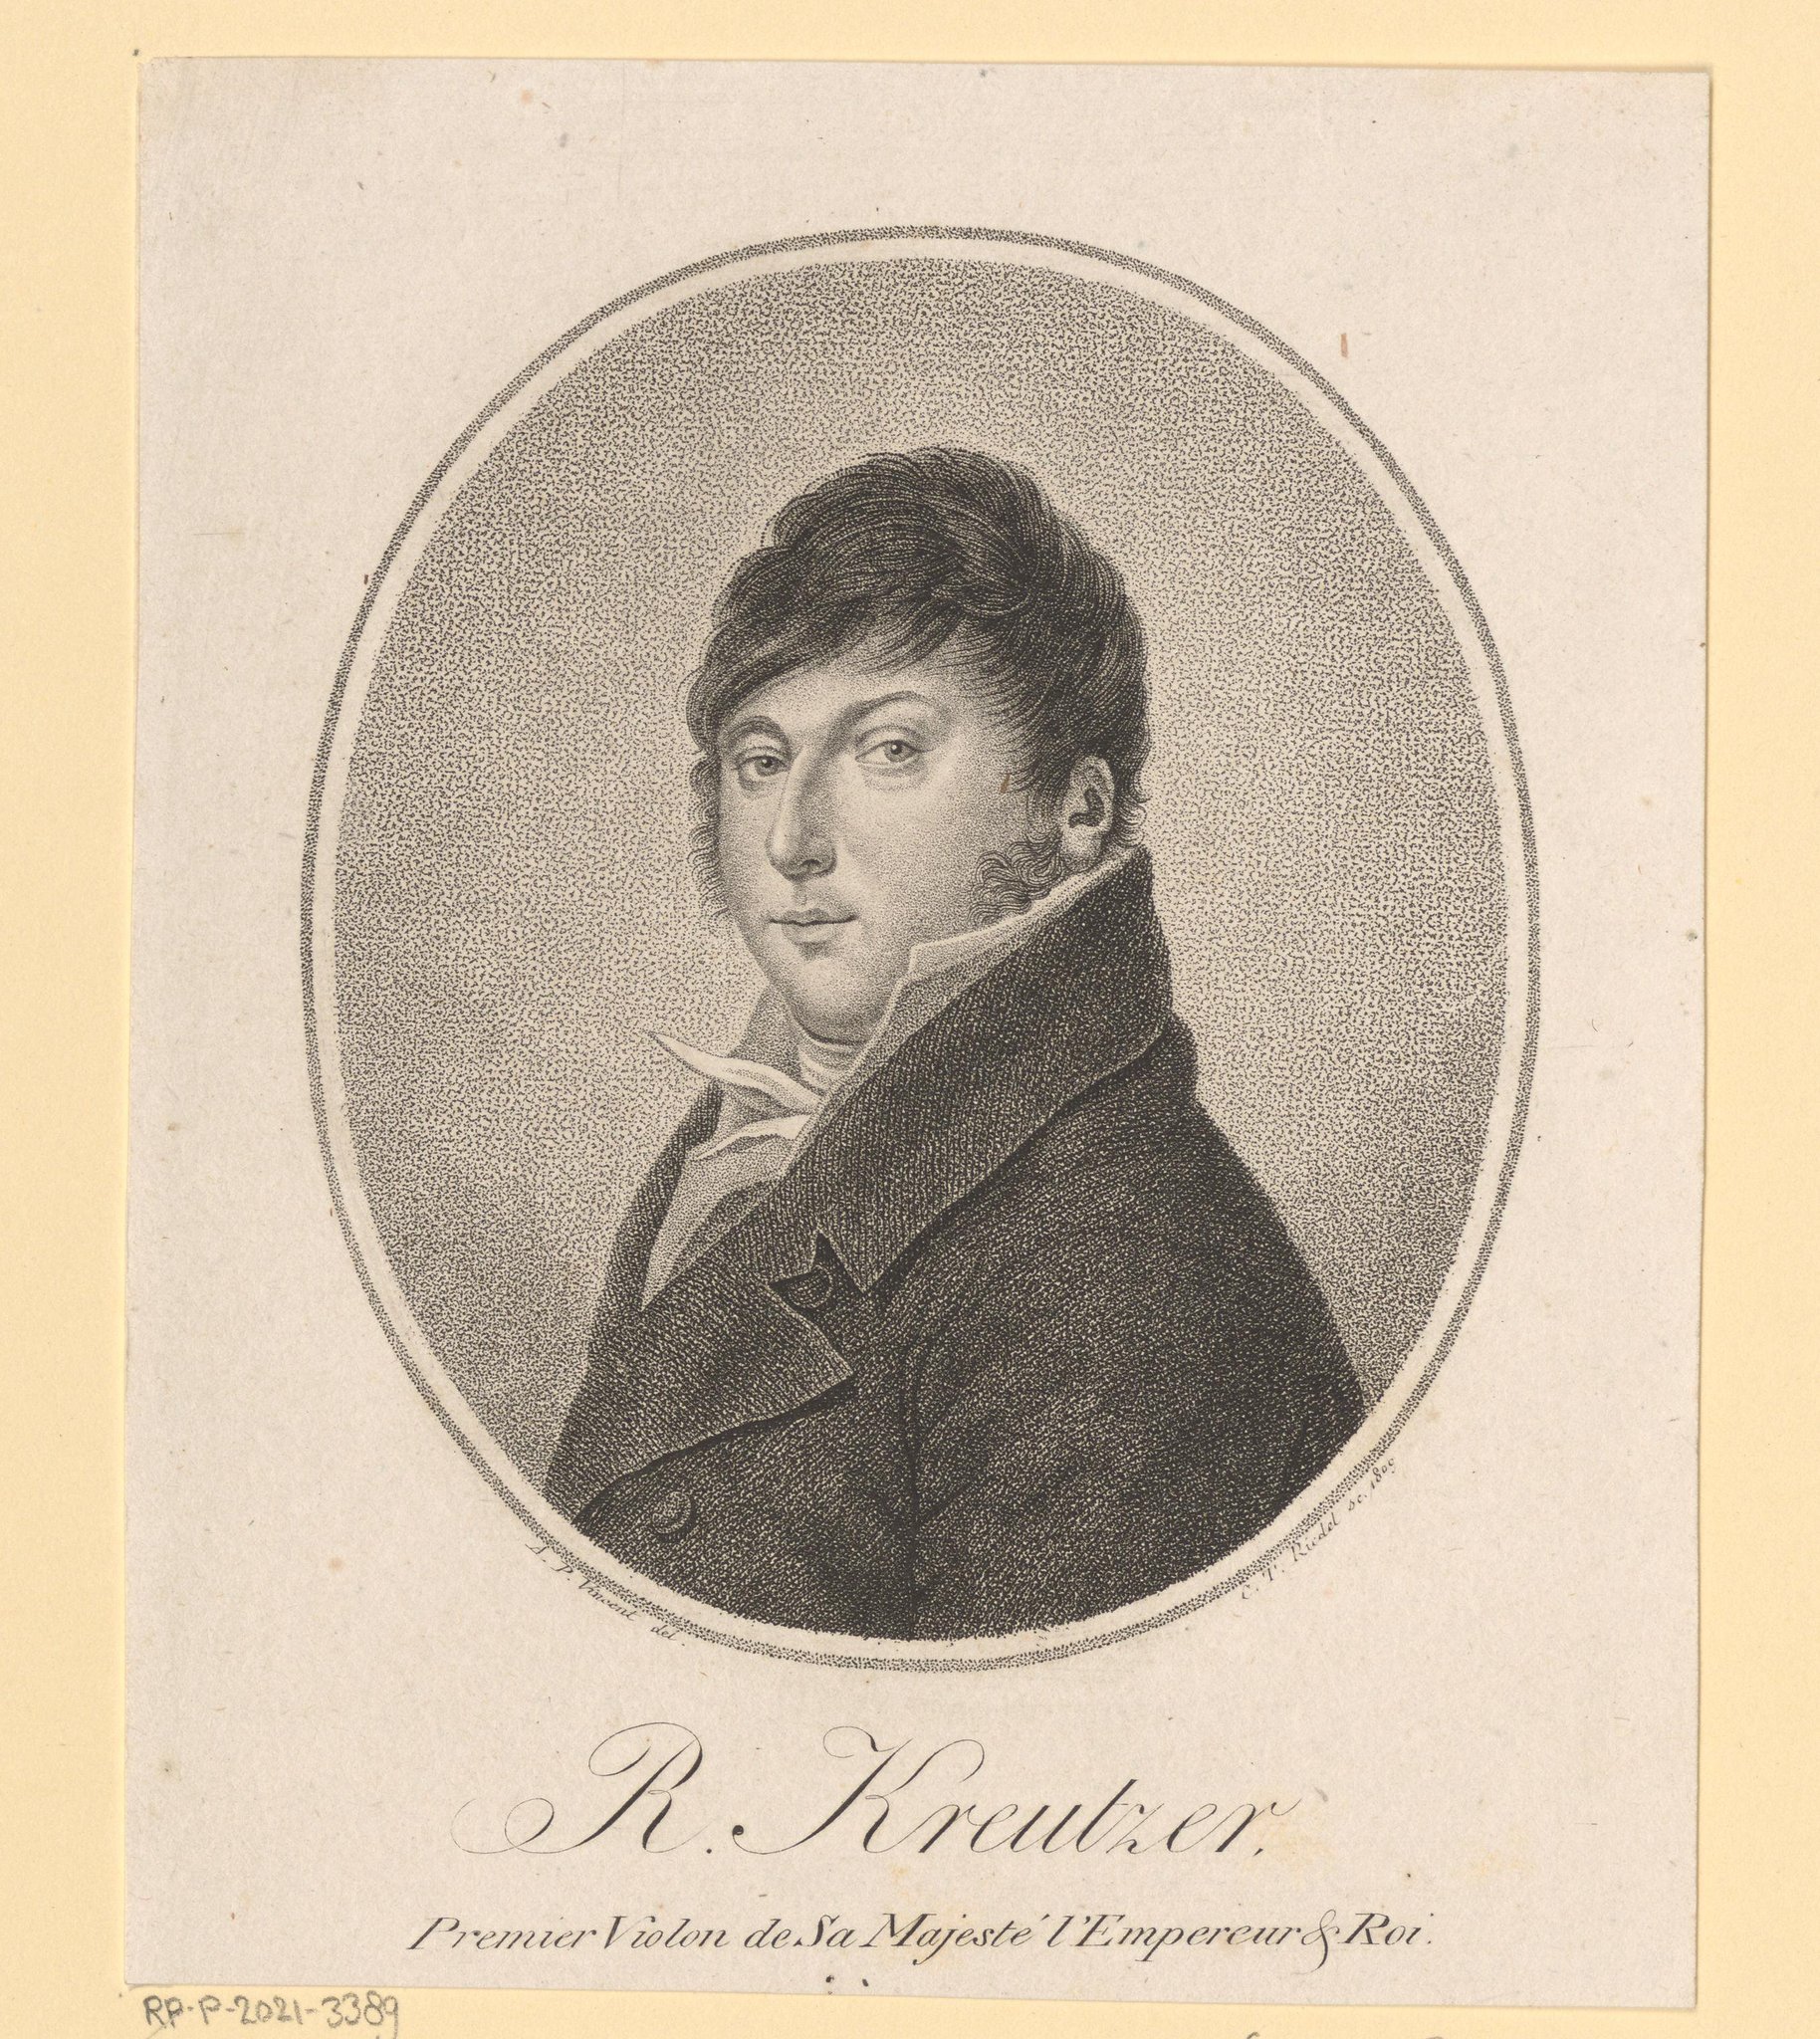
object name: print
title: Portret van Rodolphe Kreutzer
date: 1809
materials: paper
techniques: engraving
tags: historical persons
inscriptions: date